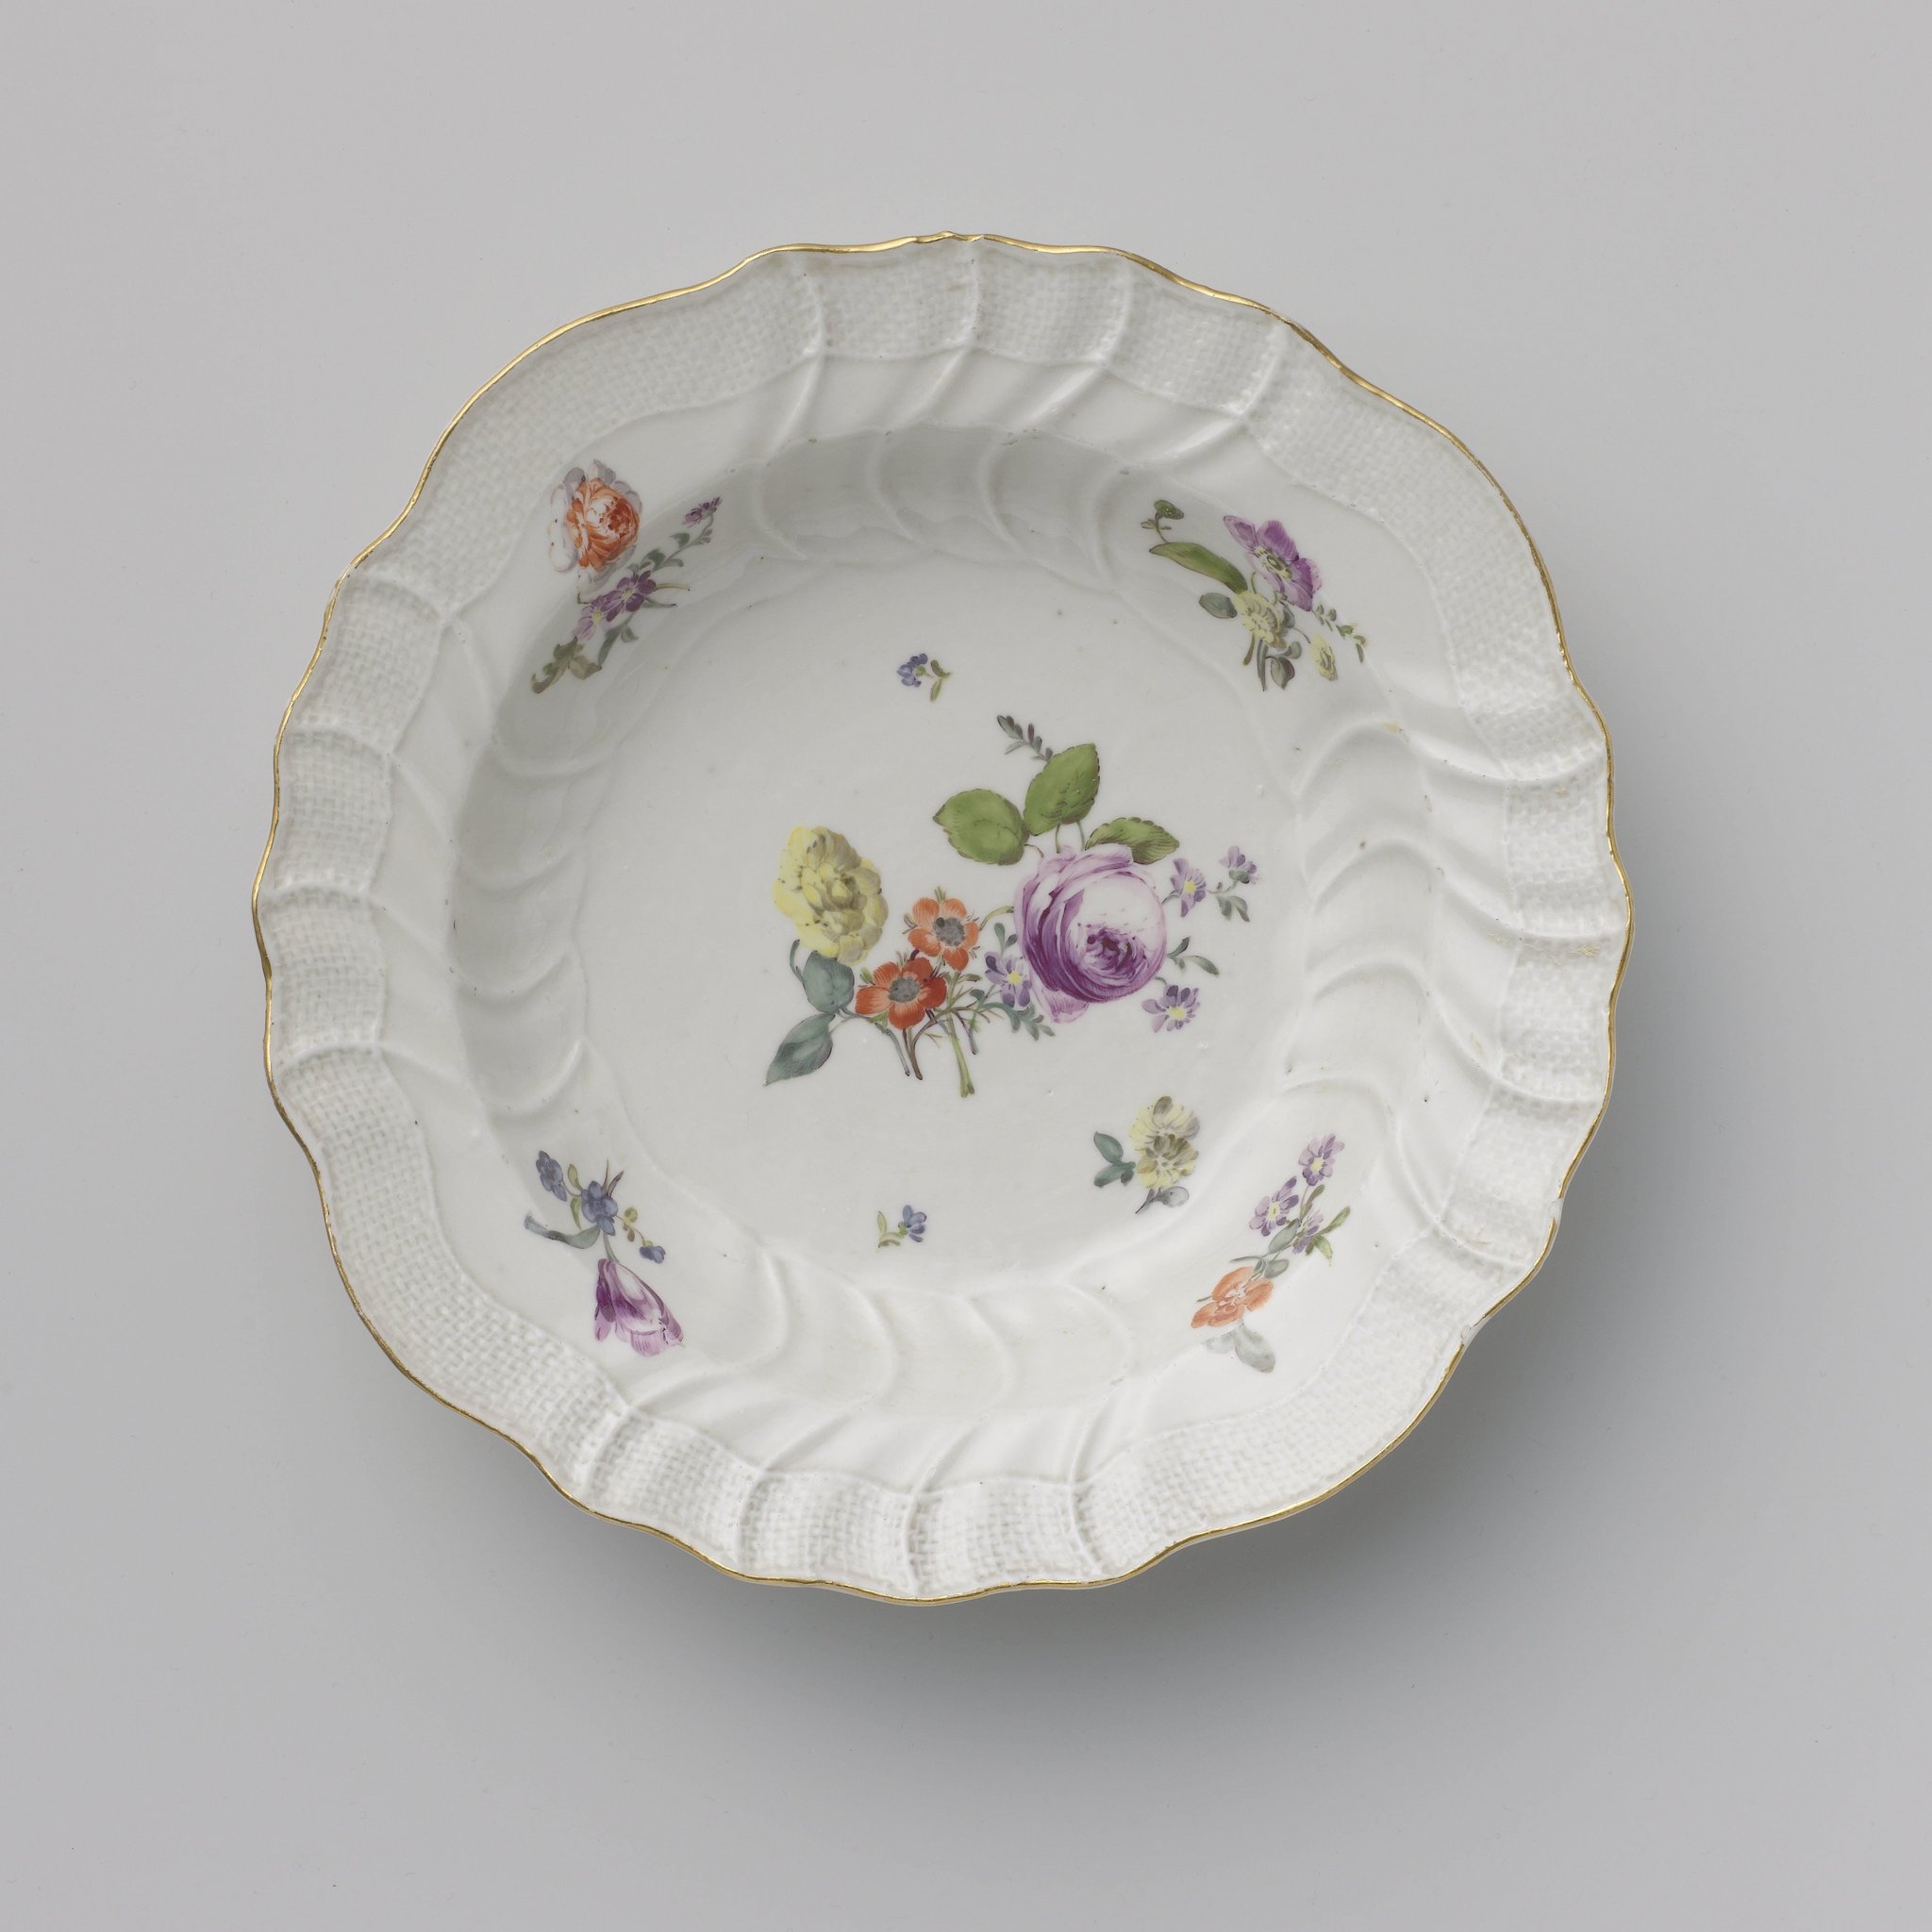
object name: eating drinking utensil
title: Bord, veelkleurig beschilderd met Deutsche Blumen, insekten en vruchten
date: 1750-1760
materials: porcelain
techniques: painted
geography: meissen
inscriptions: factory mark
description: Rond soepbord van beschilderd porselein. Het bord is beschilderd met Deutsche Blumen, insekten en vruchten. De rand is in reliëf versierd met het Neuozier-patroon. Het bord is gemerkt en hoort bij een servies (BK-17474-1 t/m BK-17474-253).